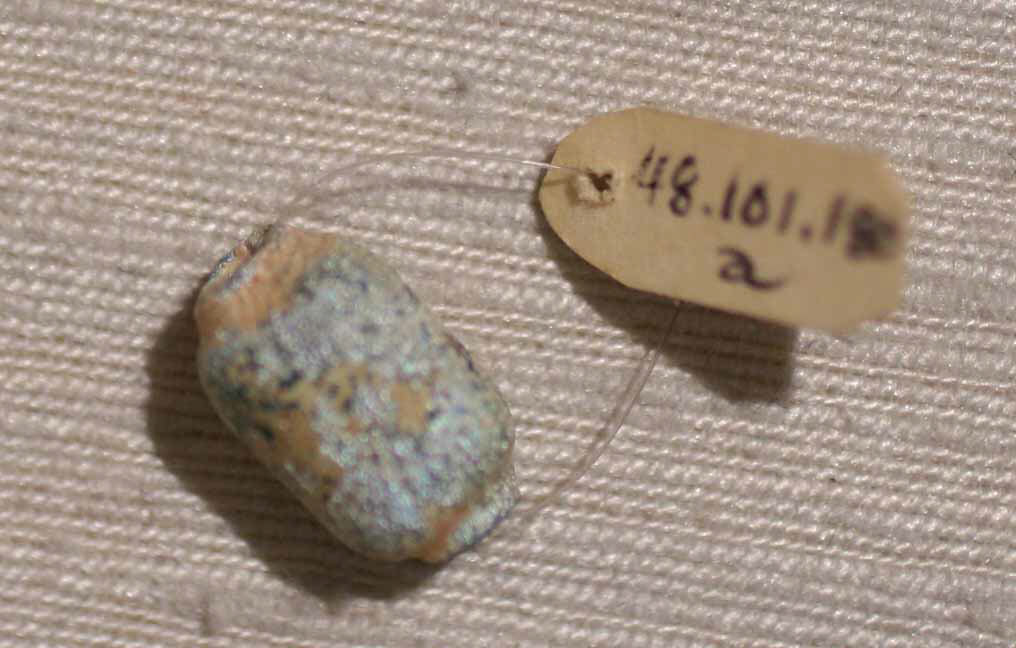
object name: bead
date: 701-1300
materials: ceramic, glass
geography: iran